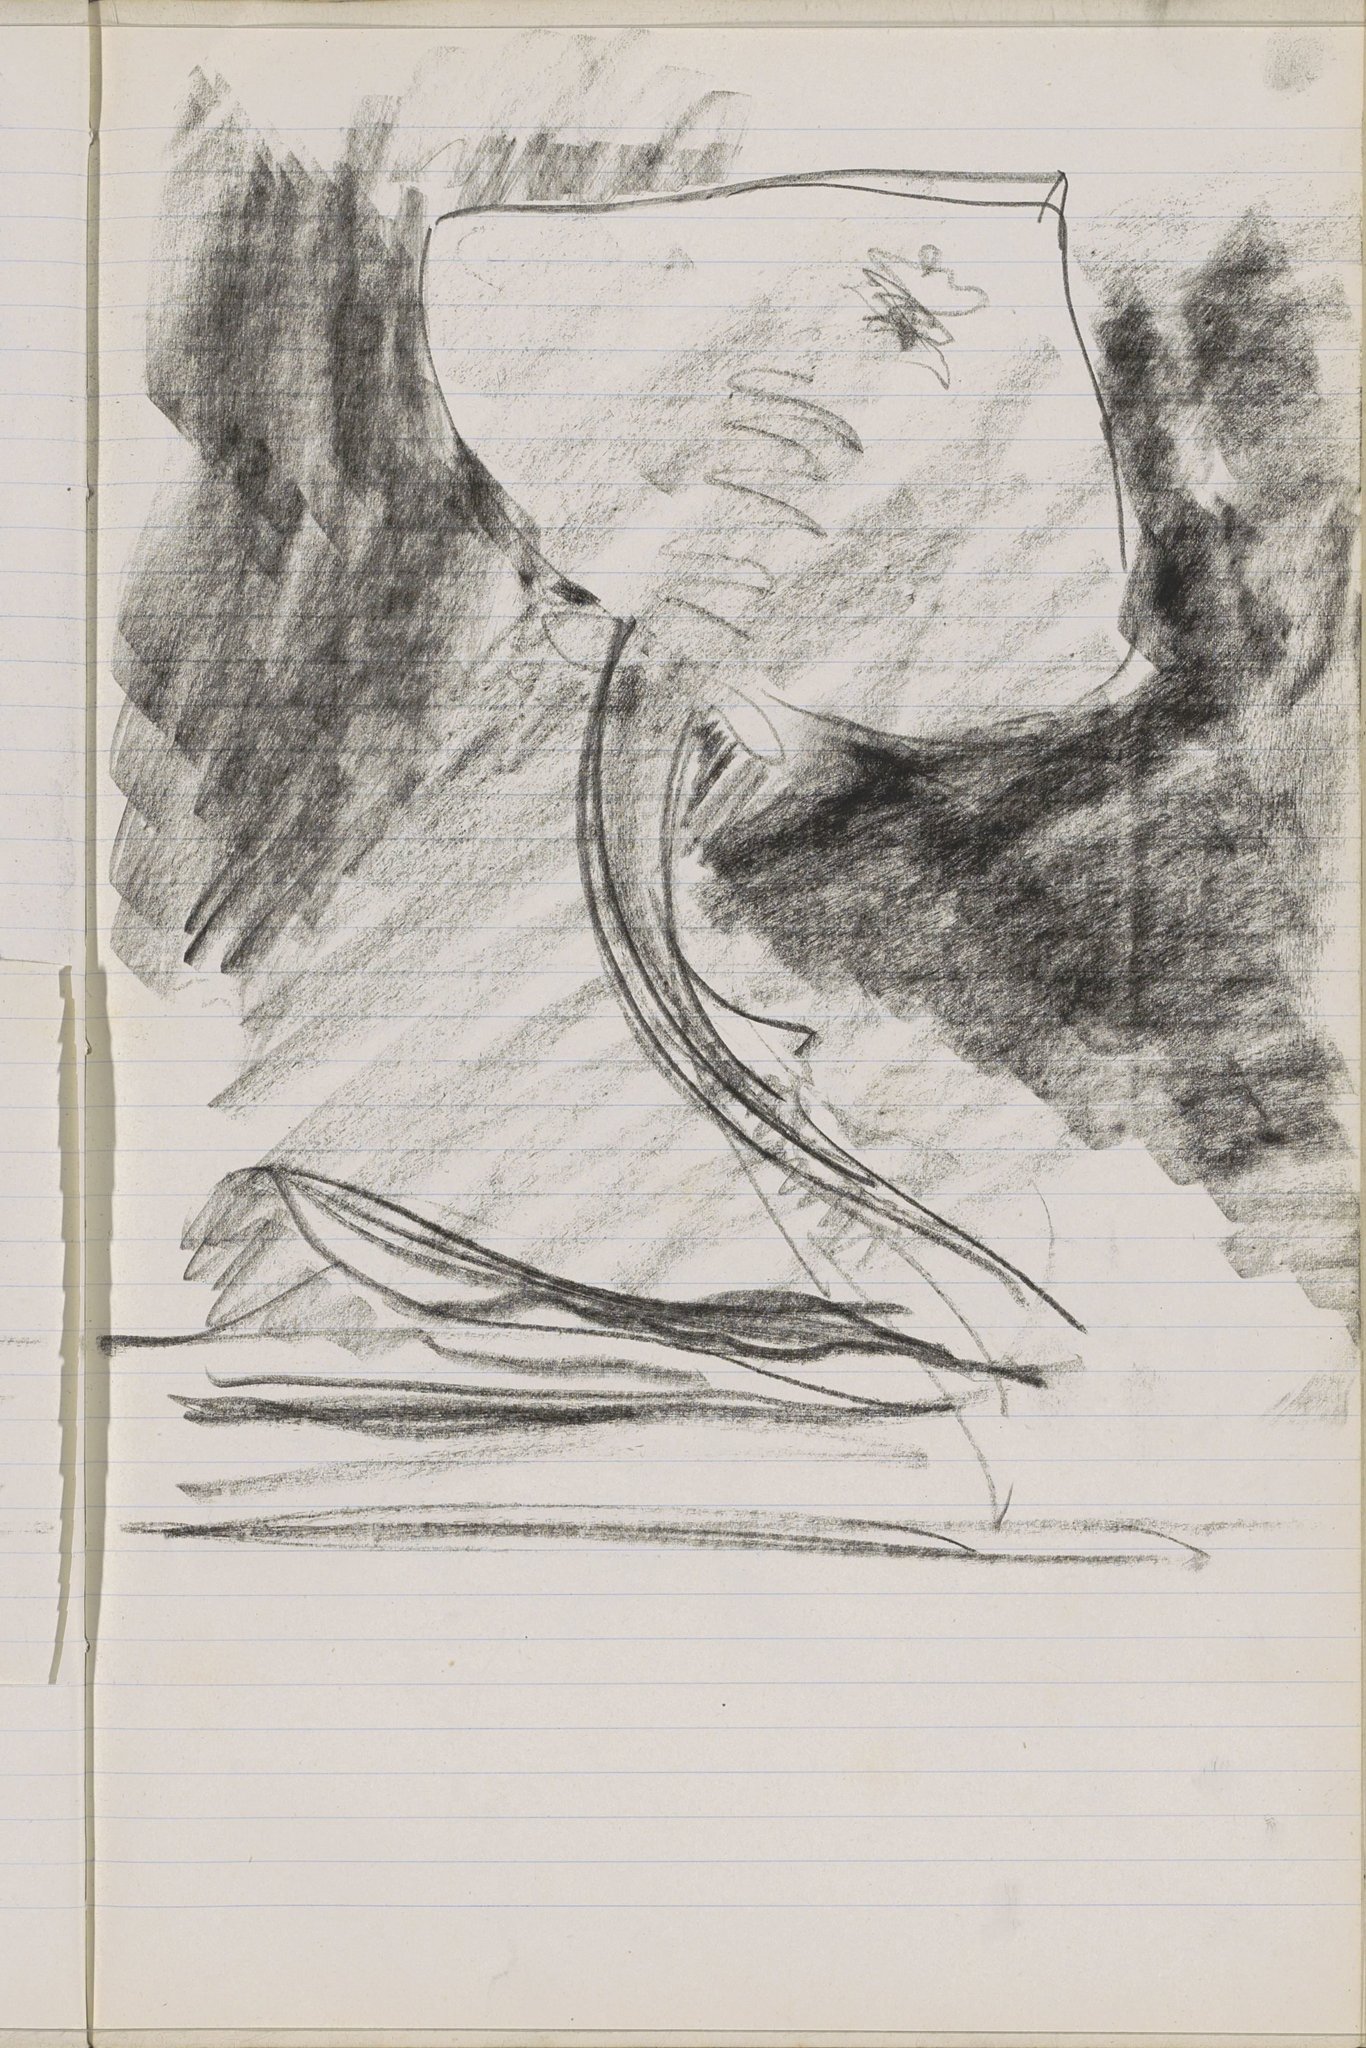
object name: sketchbook leaf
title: Pijlstaartrog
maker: gerrit willem dijsselhof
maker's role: designer, draughtsman, print maker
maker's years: 1866-1924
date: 1901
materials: chalk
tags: cartilaginous fishes: sting-ray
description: Blad 72 recto uit een schetsboek met 79 bladen.